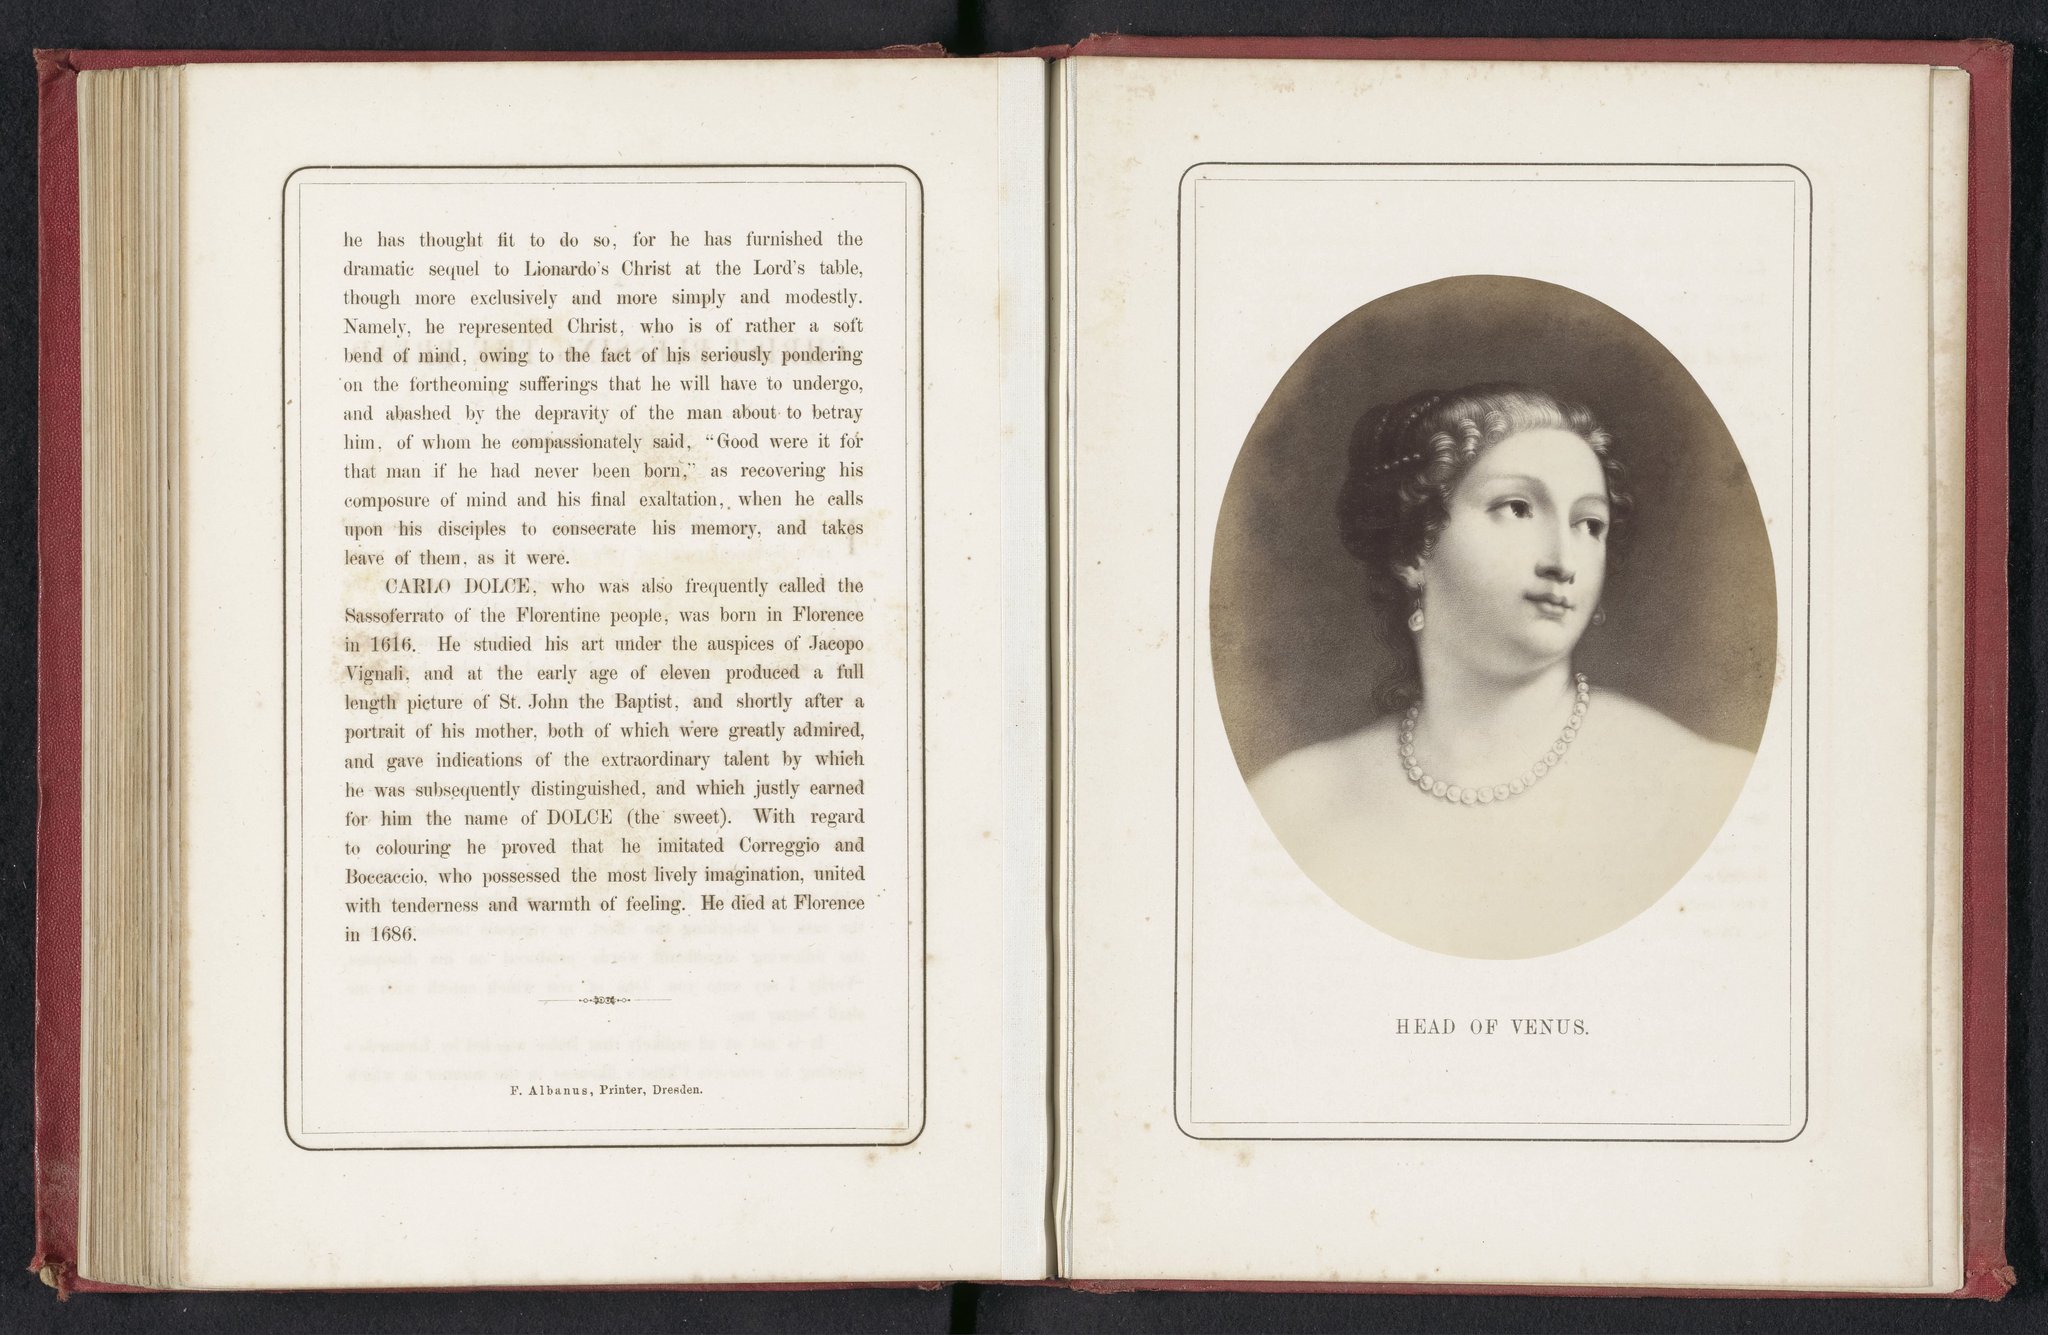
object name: photograph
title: Fotoreproductie van een portret van Venus door Titiaan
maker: hanns hanfstaengl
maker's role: print maker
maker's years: 1820-1885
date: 1854-1864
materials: photographic support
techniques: albumen print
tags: (story of) venus (aphrodite), picture, painting